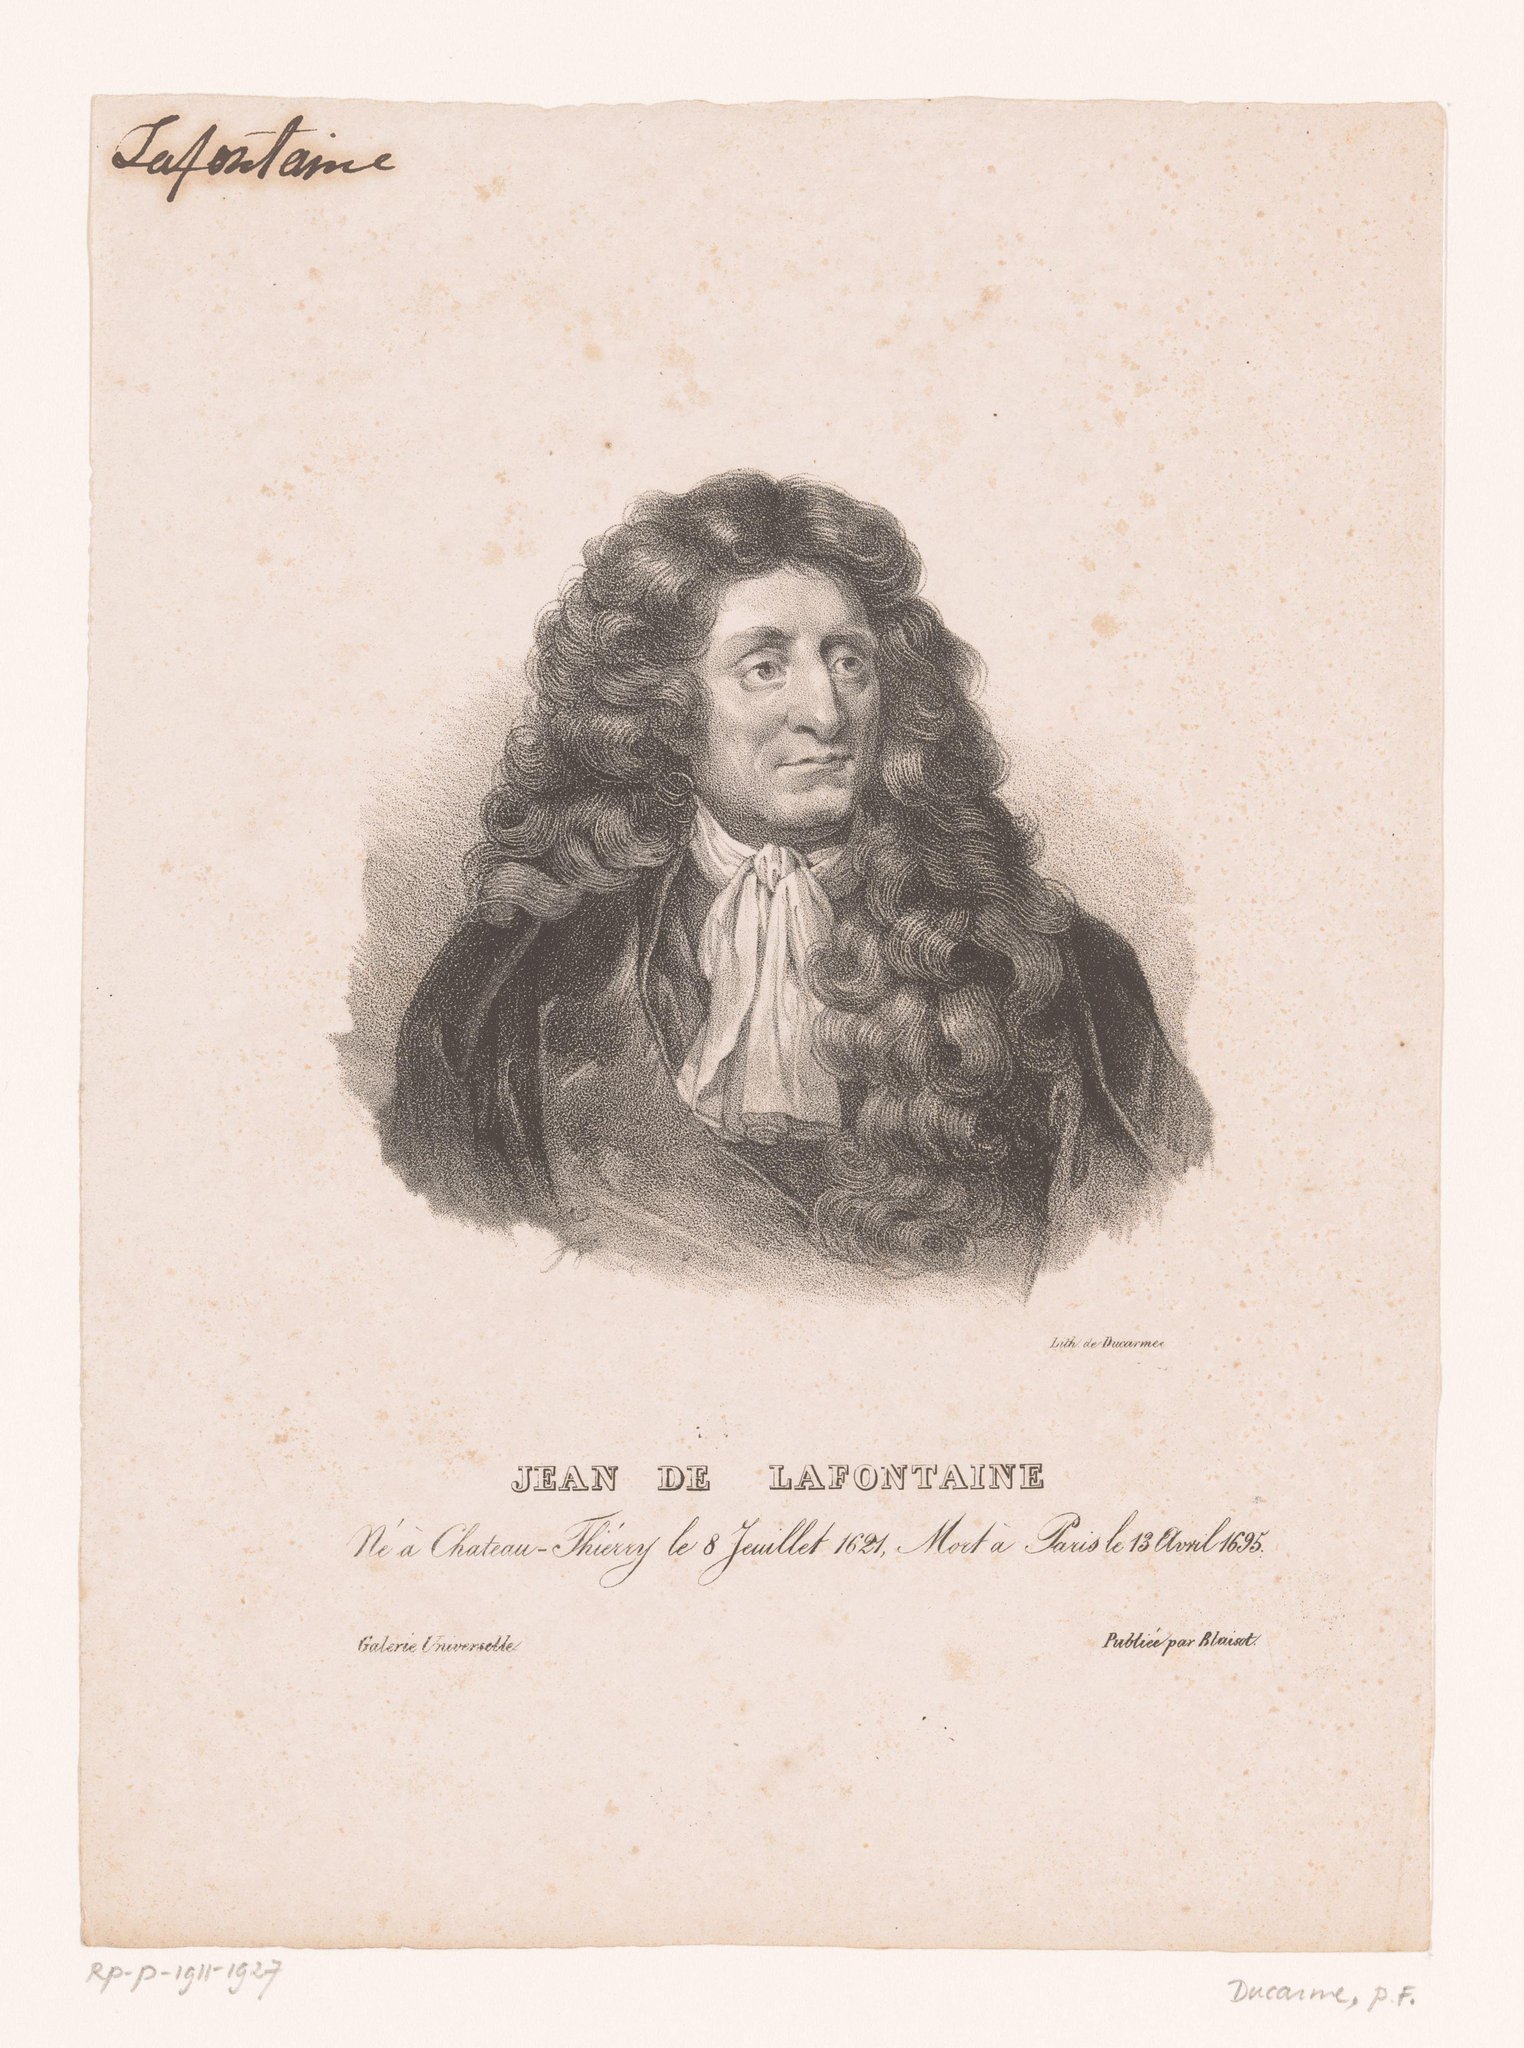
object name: print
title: Galerie universelle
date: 1820-1829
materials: paper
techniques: lithograph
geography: paris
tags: paris, jean de la fontaine, historical persons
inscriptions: annotation: ‘[...] F. 95 / F. 557’, collector's mark: Lugt 2228a